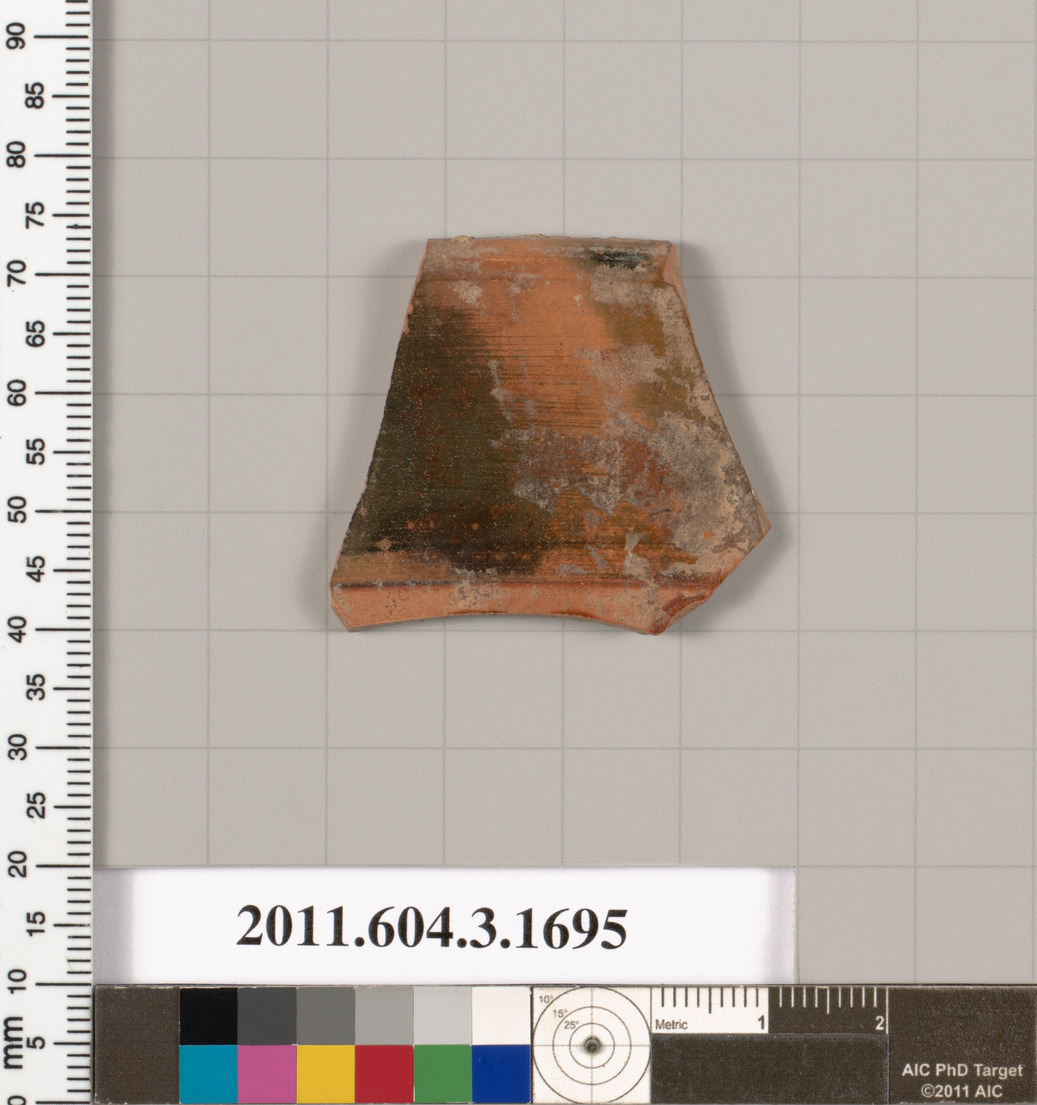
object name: kylix fragment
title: Terracotta rim fragment of a kylix: Band cup (drinking cup)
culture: greek, attic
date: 550-526 BCE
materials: terracotta